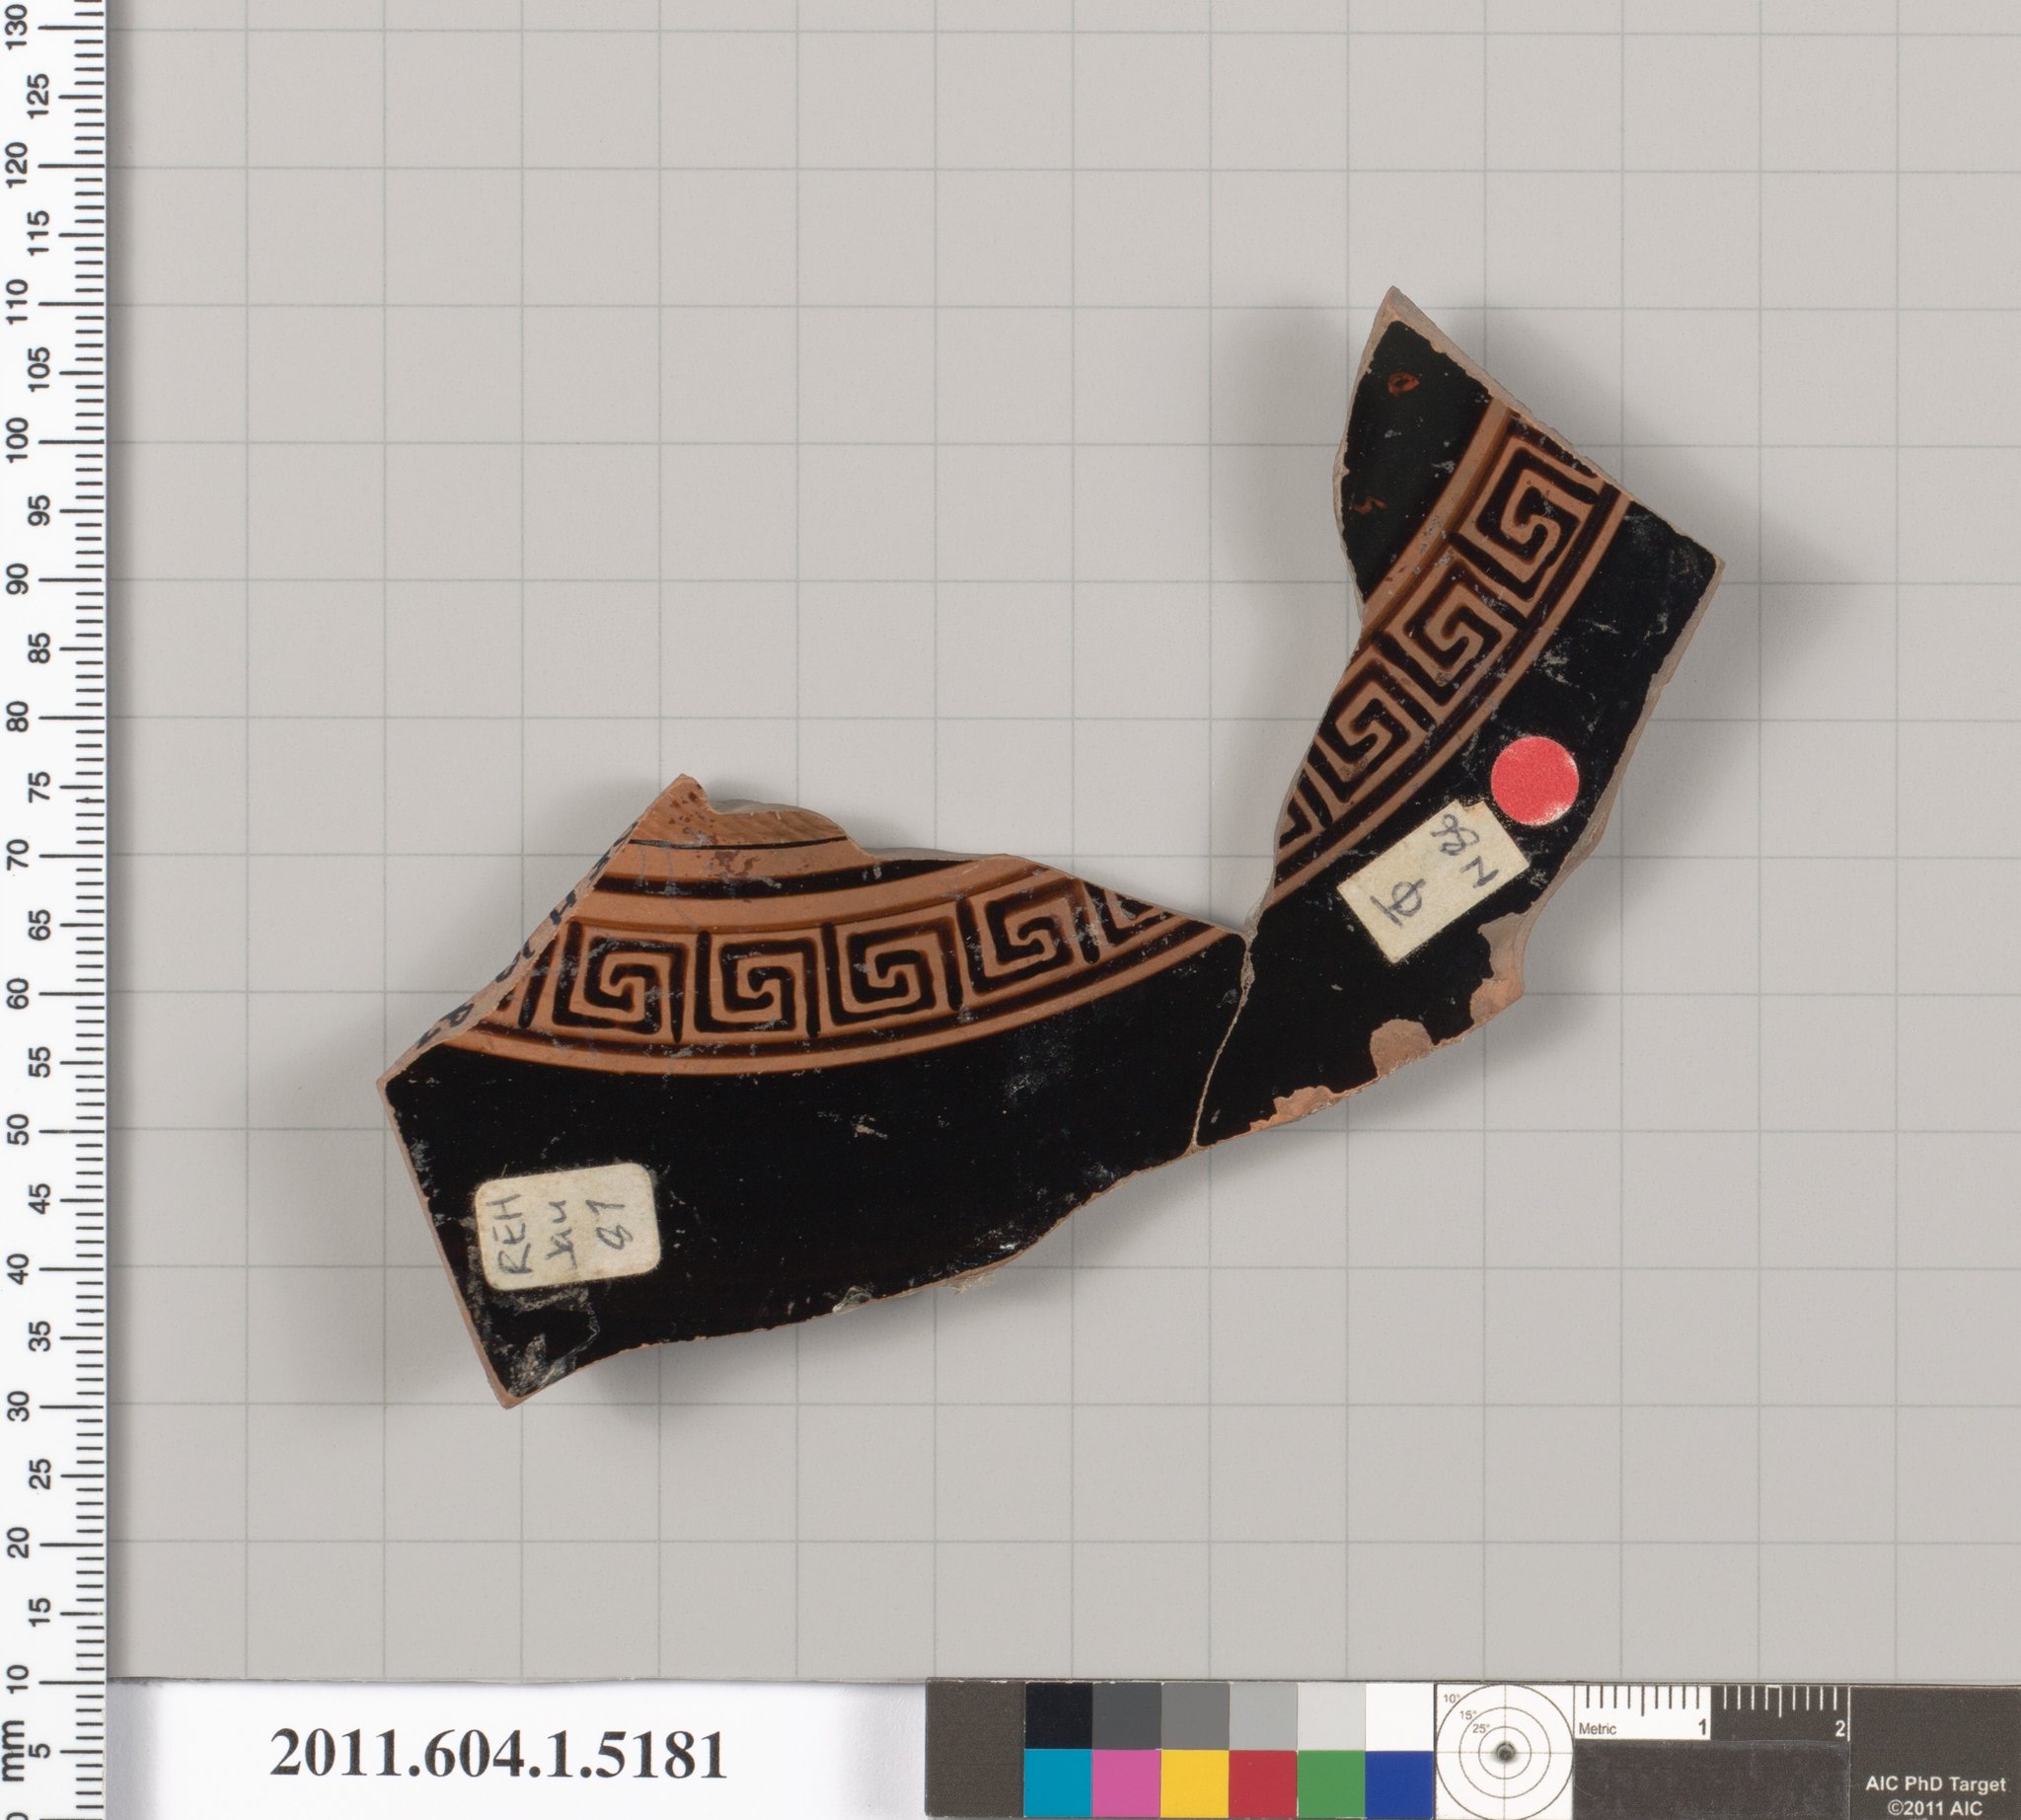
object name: kylix fragment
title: Terracotta fragment of a kylix (drinking cup)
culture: greek, attic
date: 500-476 BCE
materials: terracotta